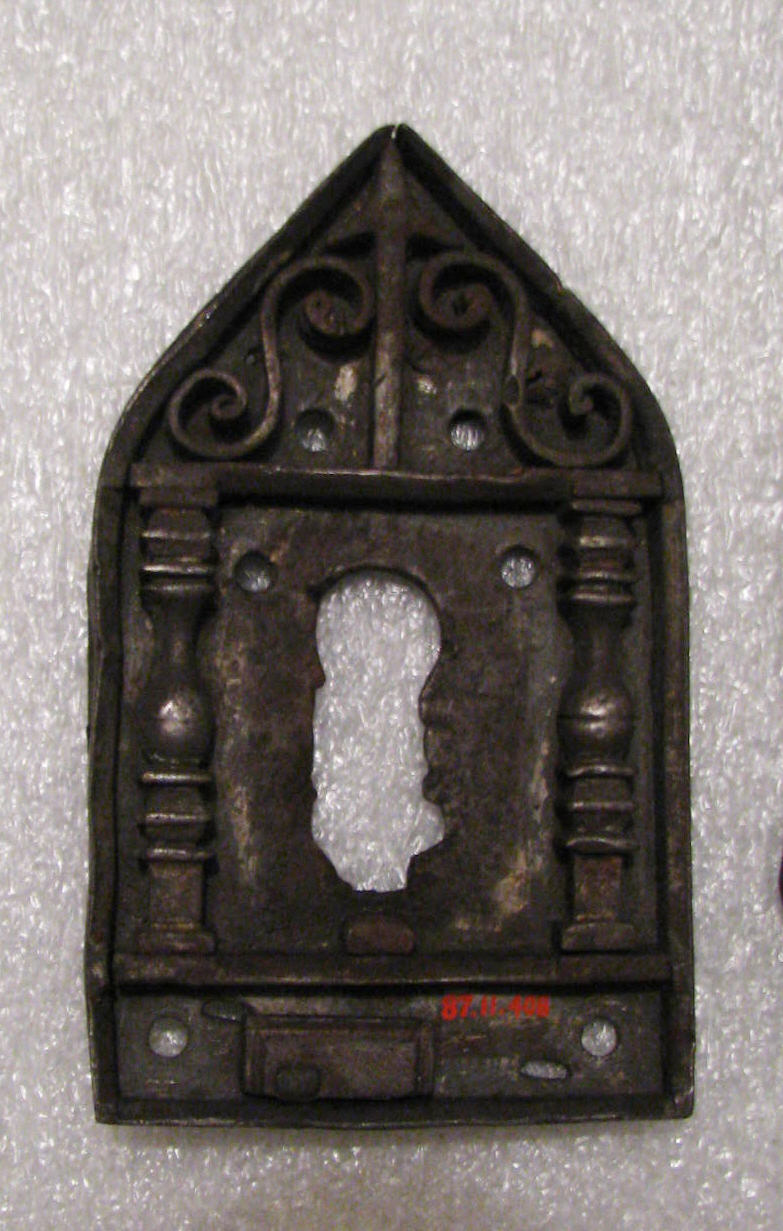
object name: escutcheon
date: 1590-1620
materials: iron